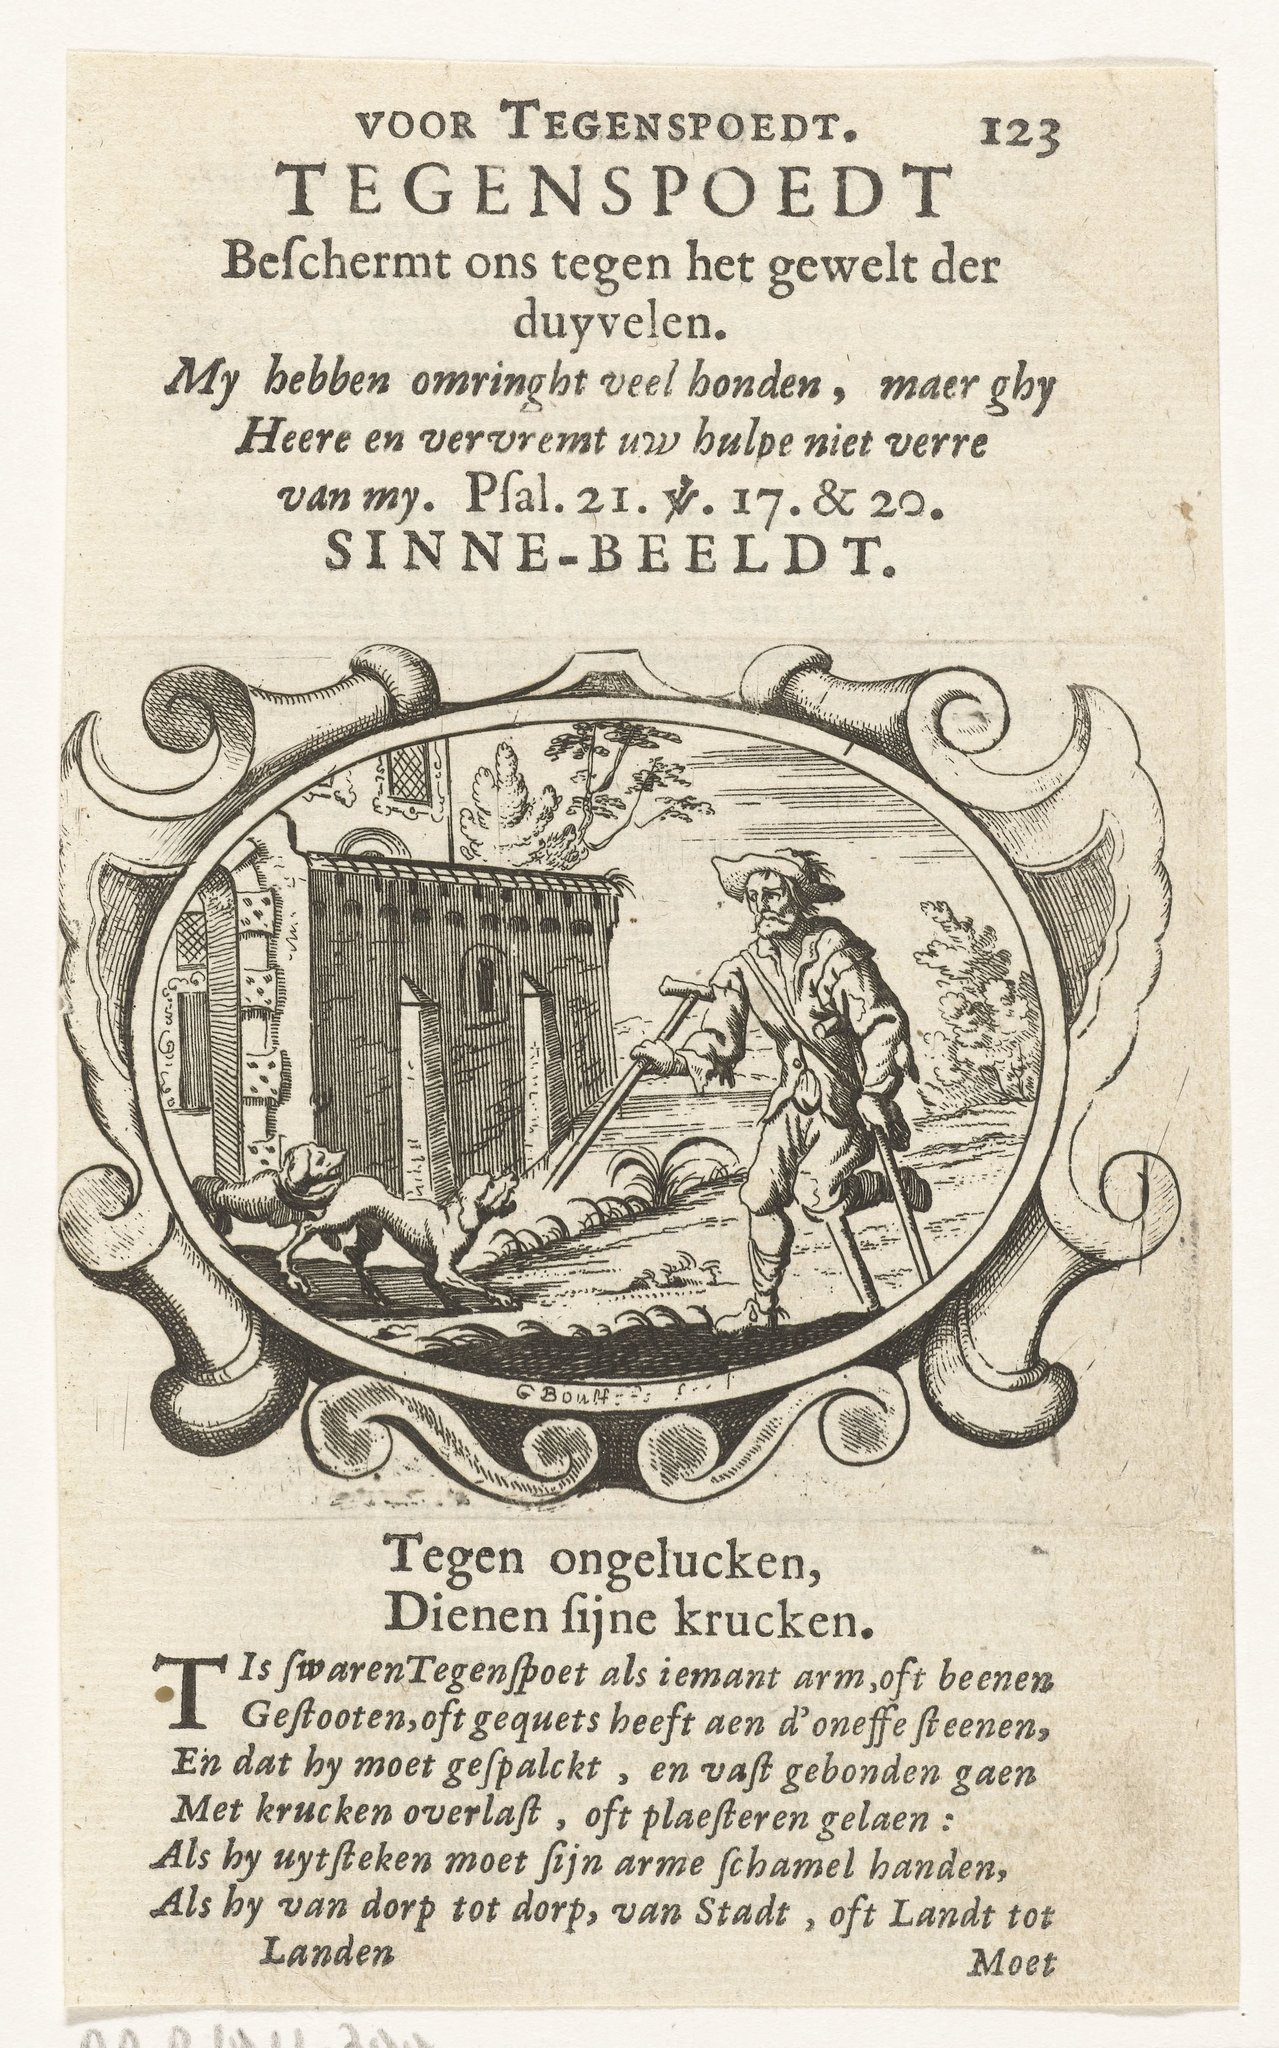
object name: book illustration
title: Tegenspoedt beschermt ons tegen het gewelt der duyvelen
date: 1679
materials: paper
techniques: engraving, etching, letterpress printing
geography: diest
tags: the book of psalms (with book chapter:verse), crutches, fight between man and animal, adversity, misfortune, bad luck; 'fortuna infelice', 'infortunio' (ripa), person with a physical disability, beggar, abstract ideas and concepts (+ emblematical representation of concept), dog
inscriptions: collector's mark: Lugt 2228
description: Bladzijde uit een boek (p. 123) met tekst op verso. In een ovale cartouche een bedelaar op krukken die twee honden met een van zijn krukken probeert weg te houden. Boven de cartouche de titel (motto) van de prent en een citaat uit de bijbel (Psalm 22:17-20). Onder de prent een onderschrift: 'Tegen ongelucken dienen fijne krucken' en een beschrijving die de prent verklaart. Een bedelaar steunend op een kniekruk is te beklagen, maar kan zich verdedigen tegen honden met zijn krukken, vergelijkbaar moet een mens zijn tegenspoed in het leven gebruiken om zich te sterken tegen de duivel.